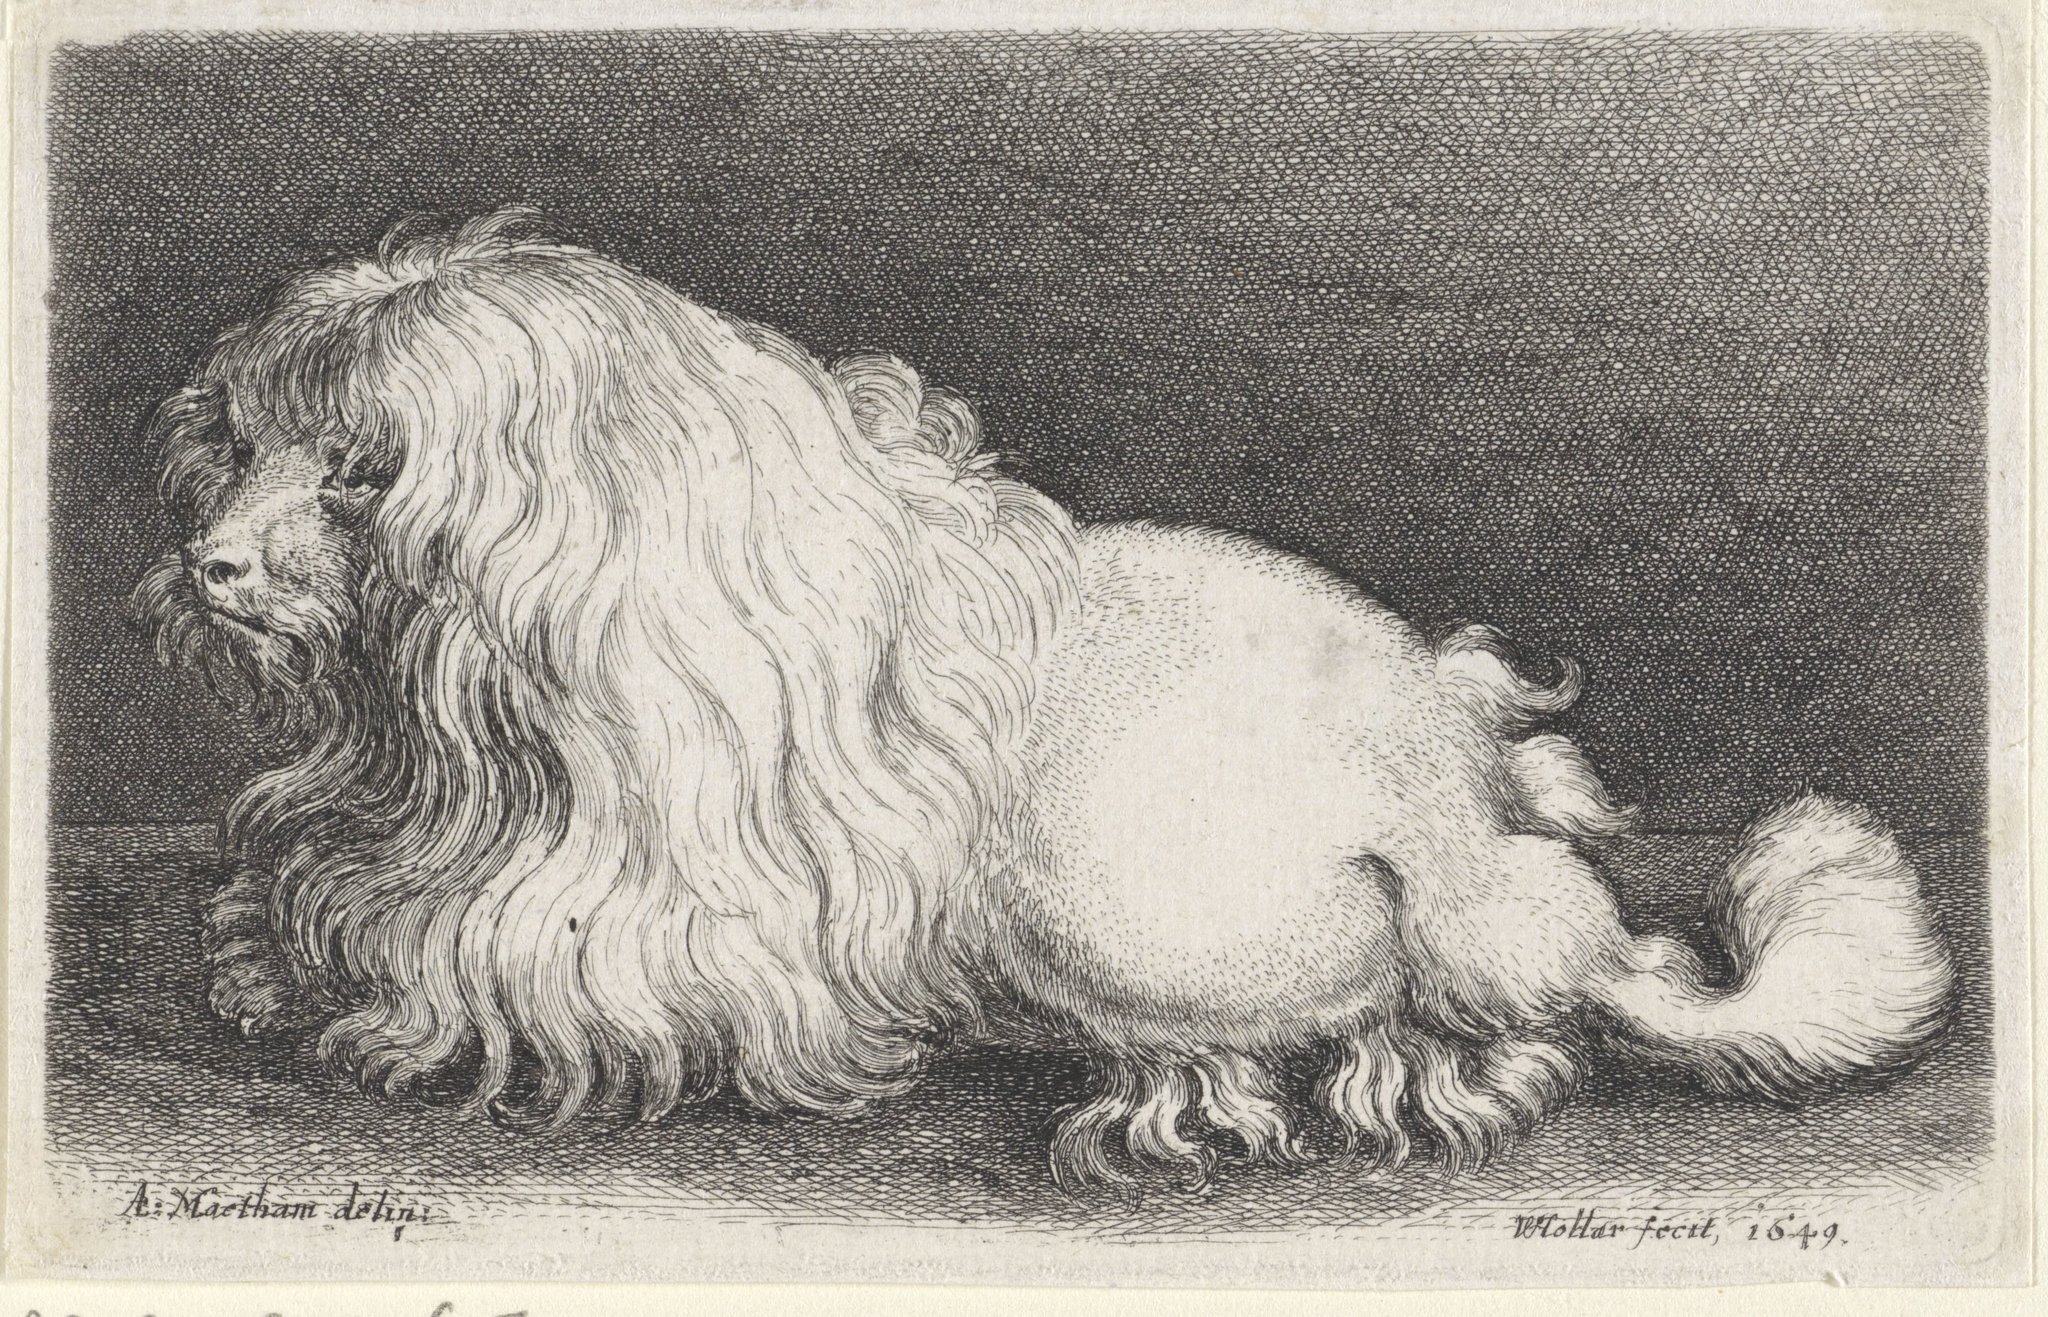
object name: print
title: Witte hond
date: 1649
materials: paper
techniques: etching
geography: antwerp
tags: dog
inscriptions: collector's mark: Lugt 2228